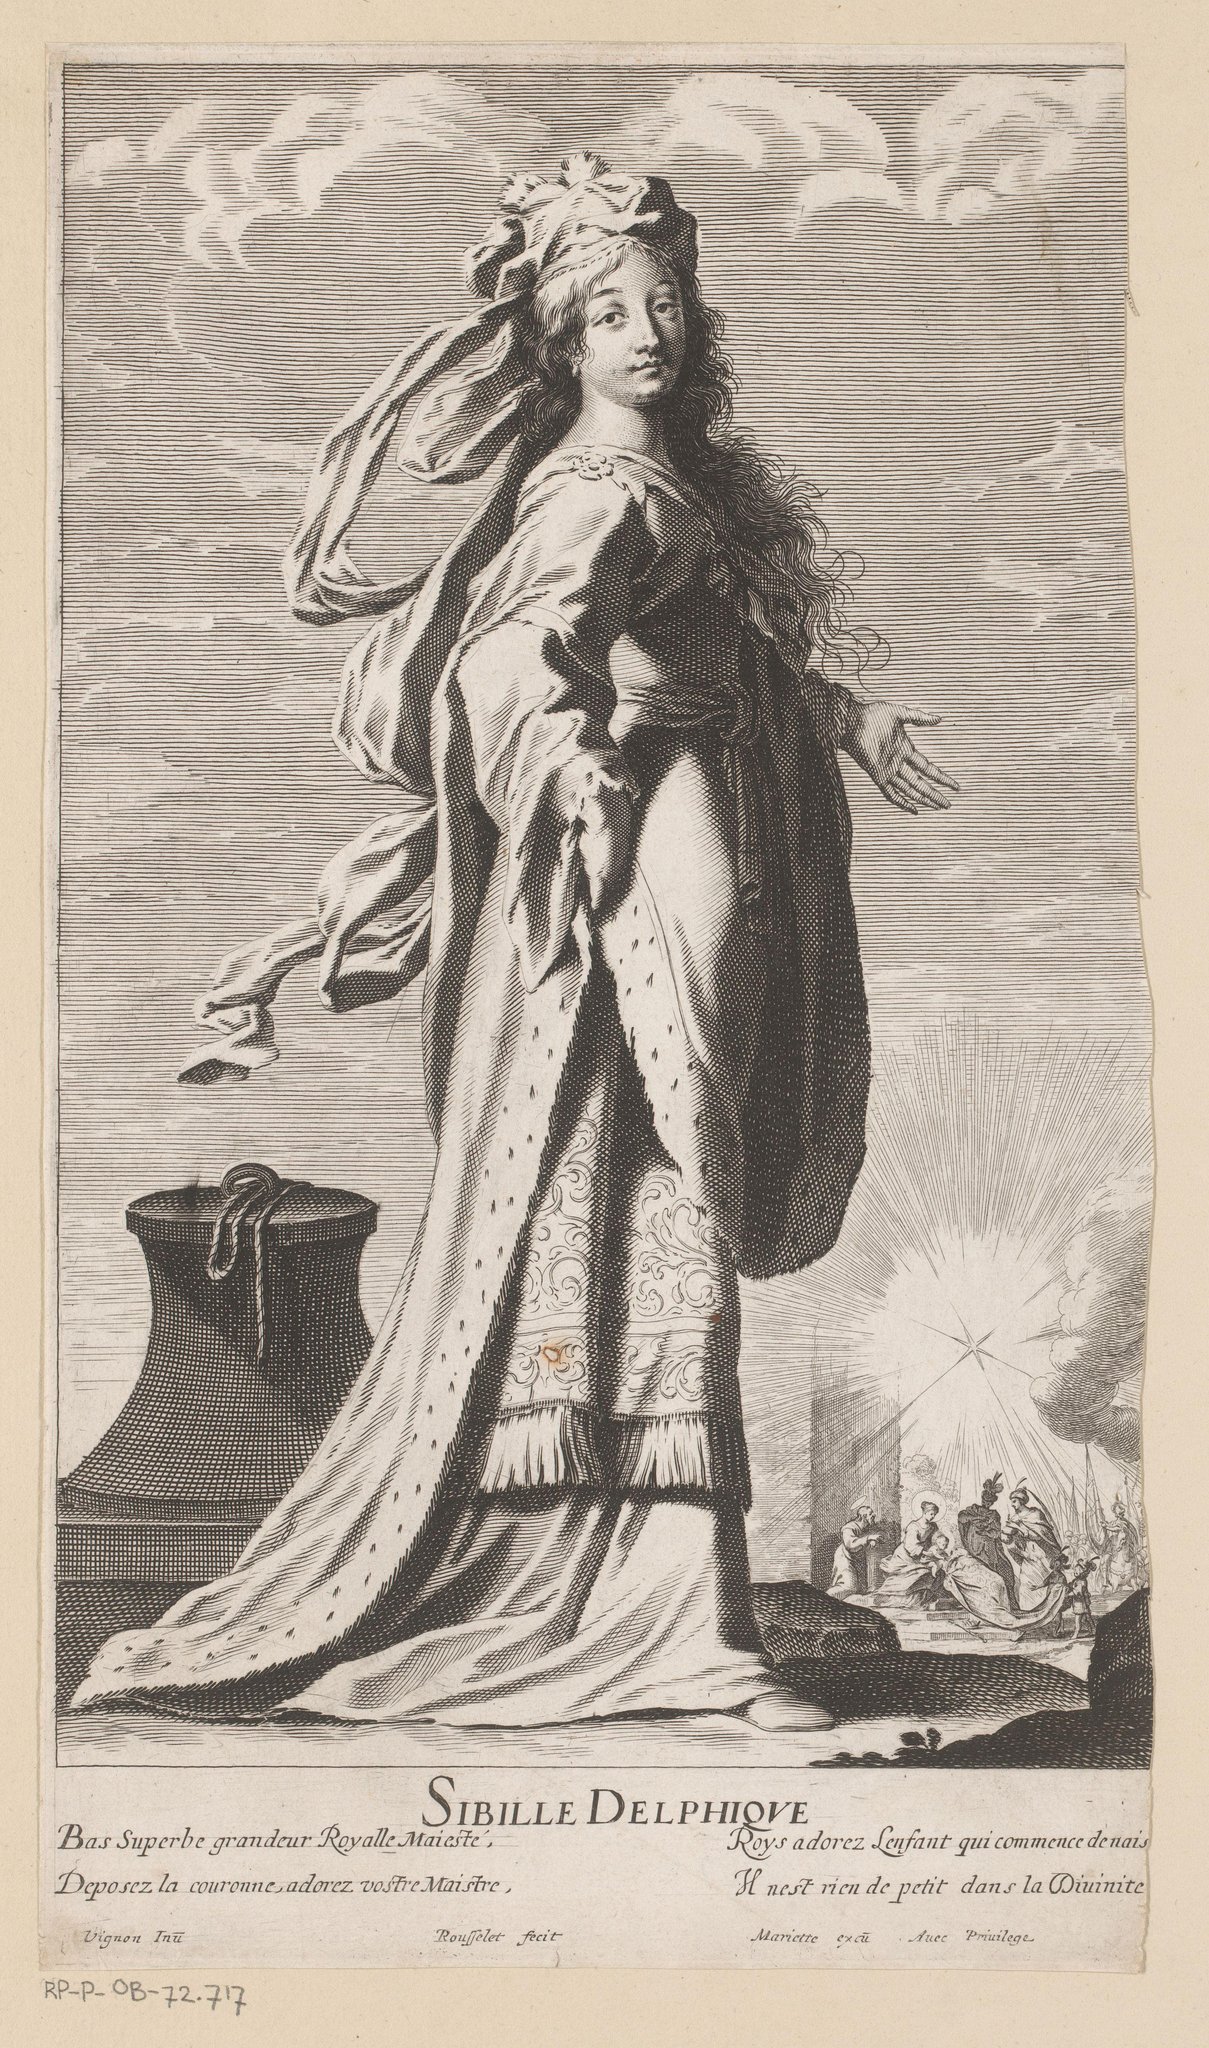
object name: print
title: Delphische sibille, met op de achtergrond de aanbidding door de koningen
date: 1635-1640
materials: paper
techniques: engraving, etching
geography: france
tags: the story of the three wise men (kings or magi) (matthew 2:1-12), sibyls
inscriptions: collector's mark: Lugt 240